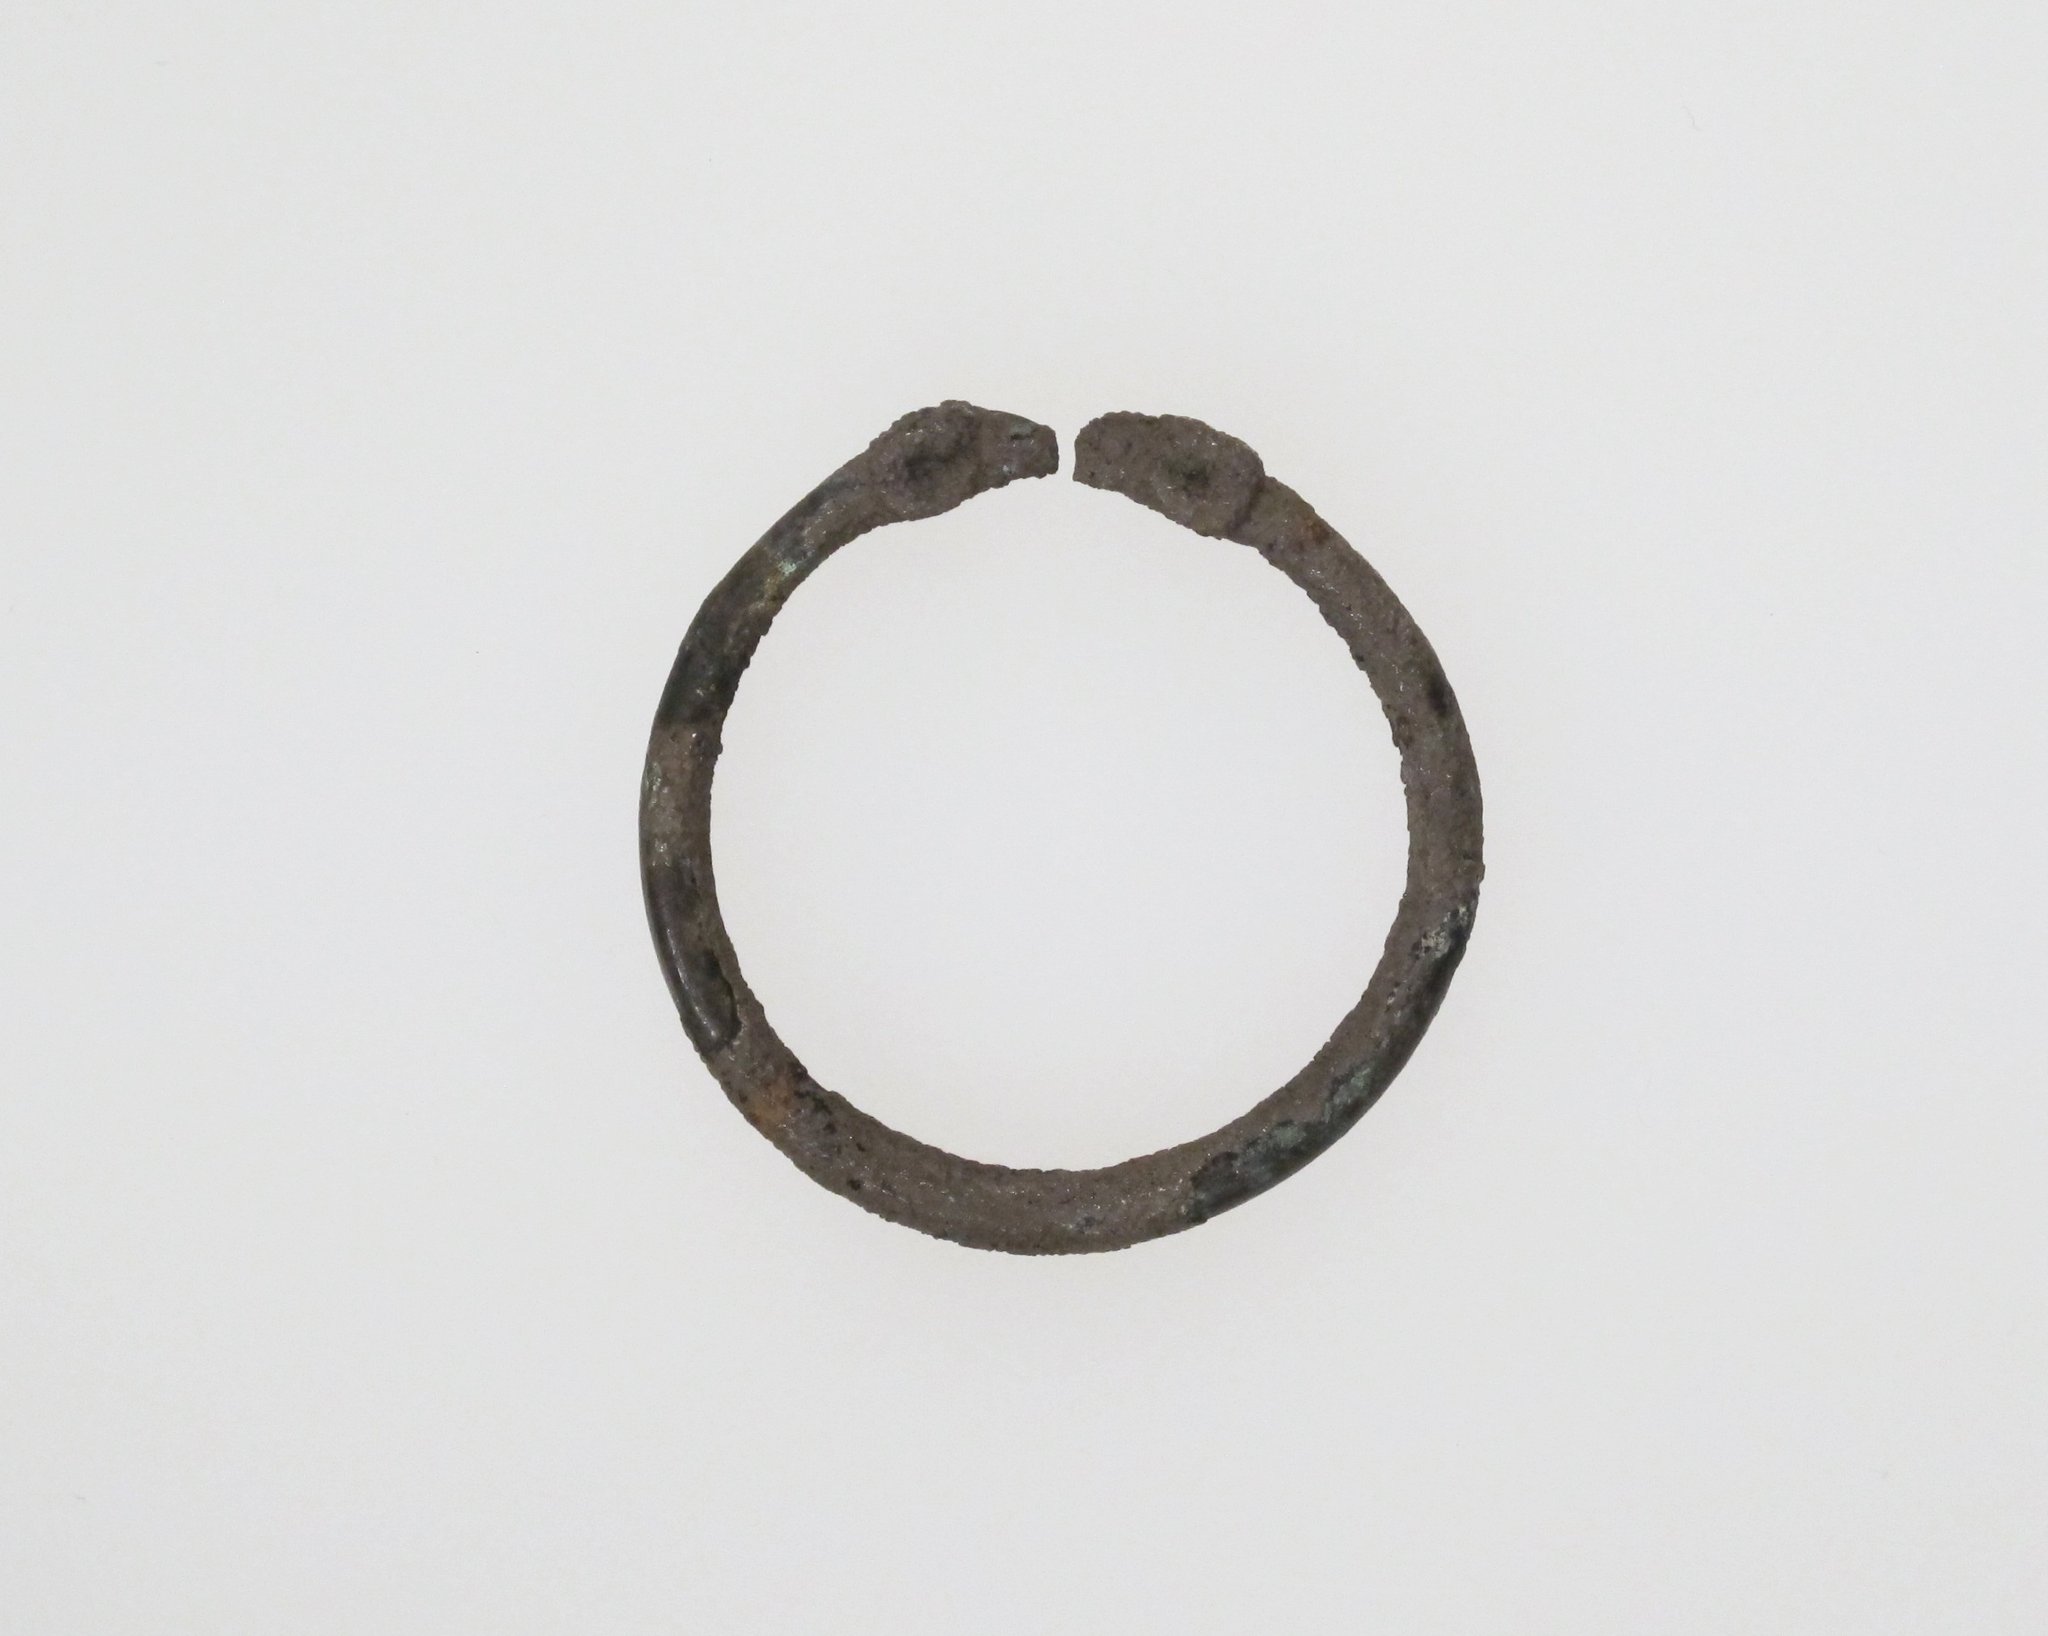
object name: bracelet with rams' head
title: Bracelet with rams' heads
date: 7000 BCE-330 CE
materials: silver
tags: rams